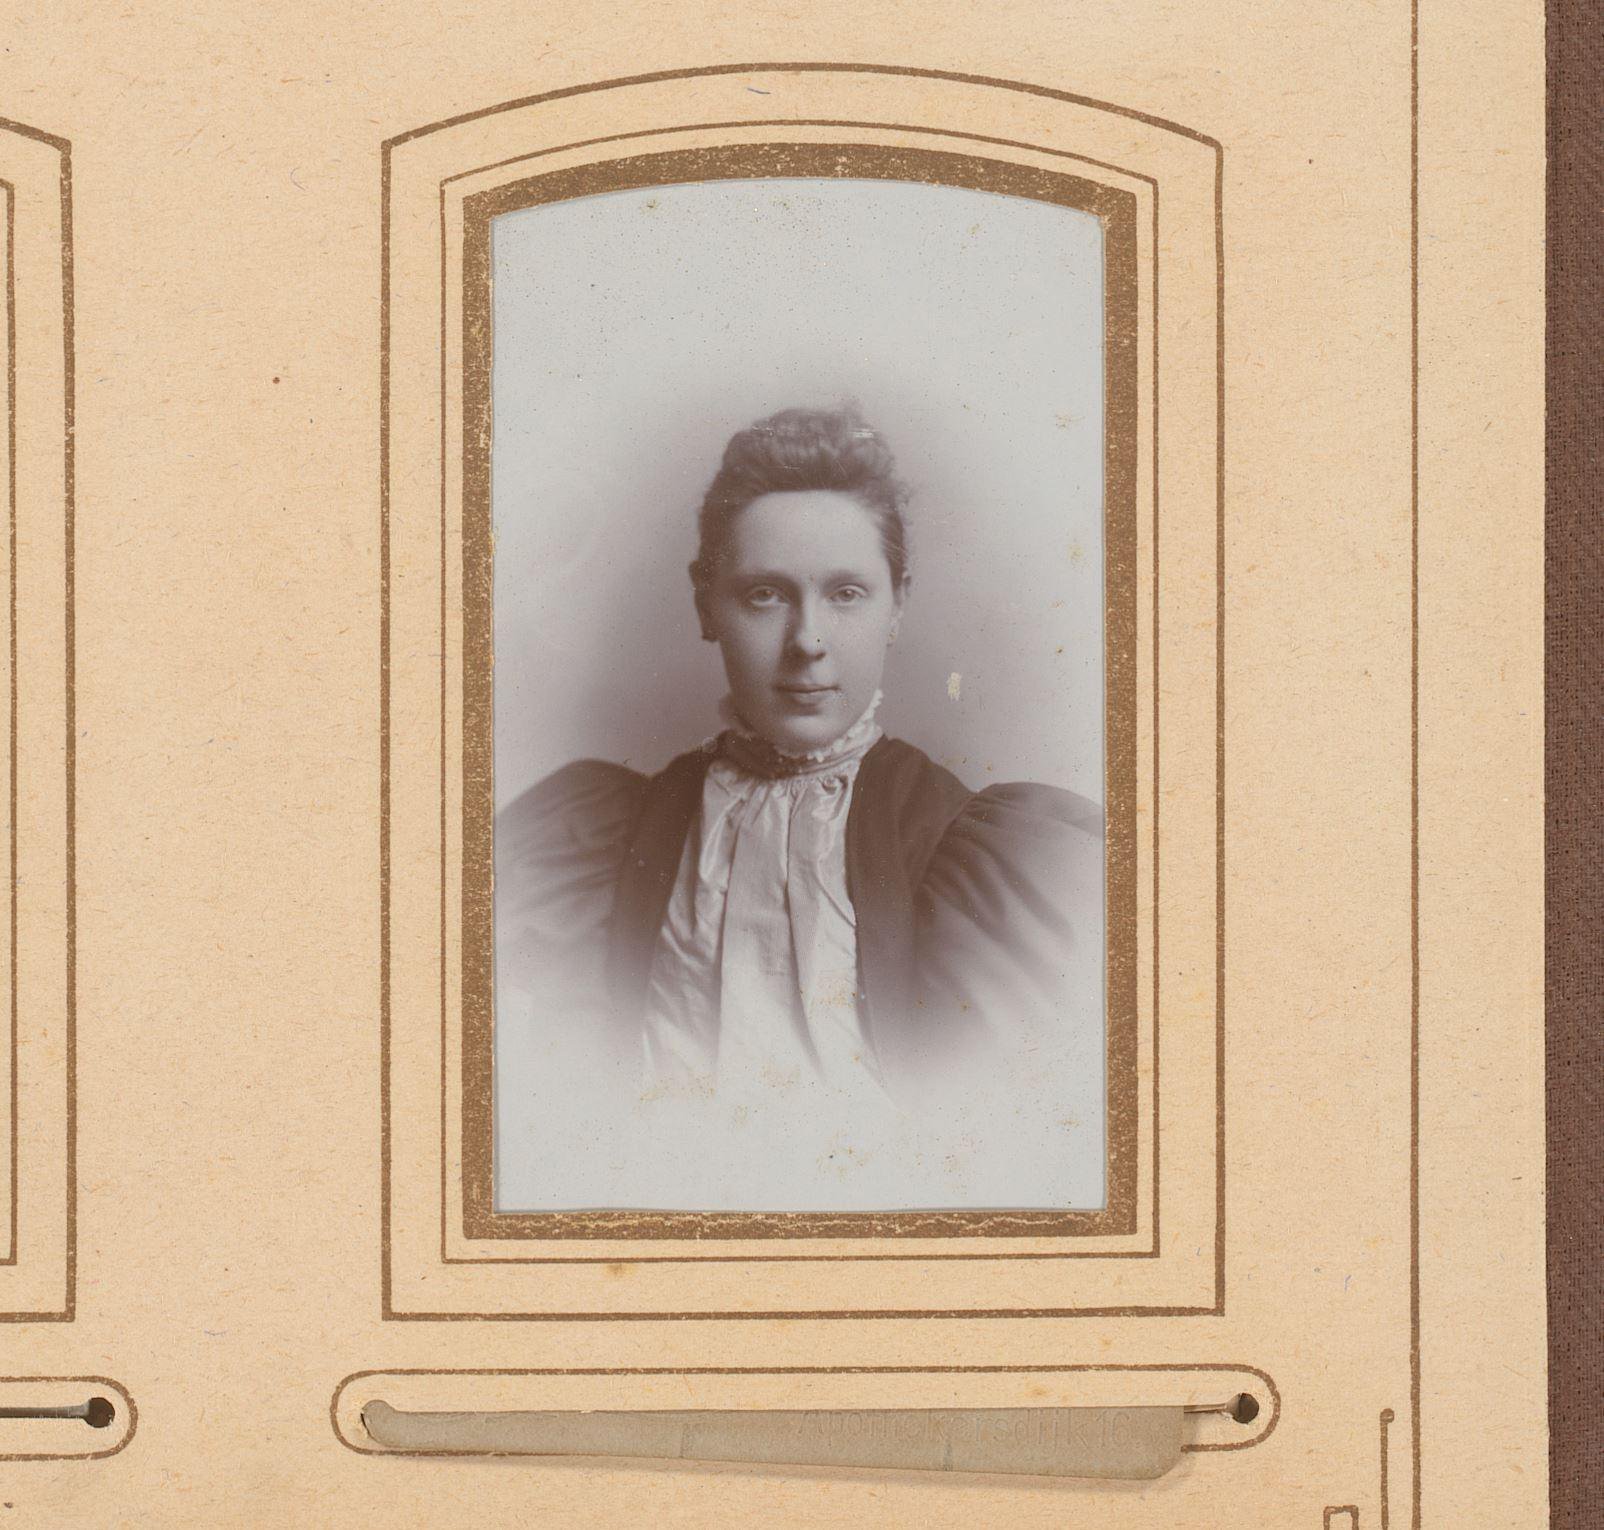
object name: photograph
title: Portret van Anna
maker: willem bongenaar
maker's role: fotograaf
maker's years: 1870-1936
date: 1804-1897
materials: cardboard, photographic support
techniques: collodion silver print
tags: adult woman, historical persons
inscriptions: annotation: ‘Nicht Anna April 1897’, inscription: ‘Photogr. Atelier/ Willem Bongenaar/ Leiden/ Apothekersdijk 16’